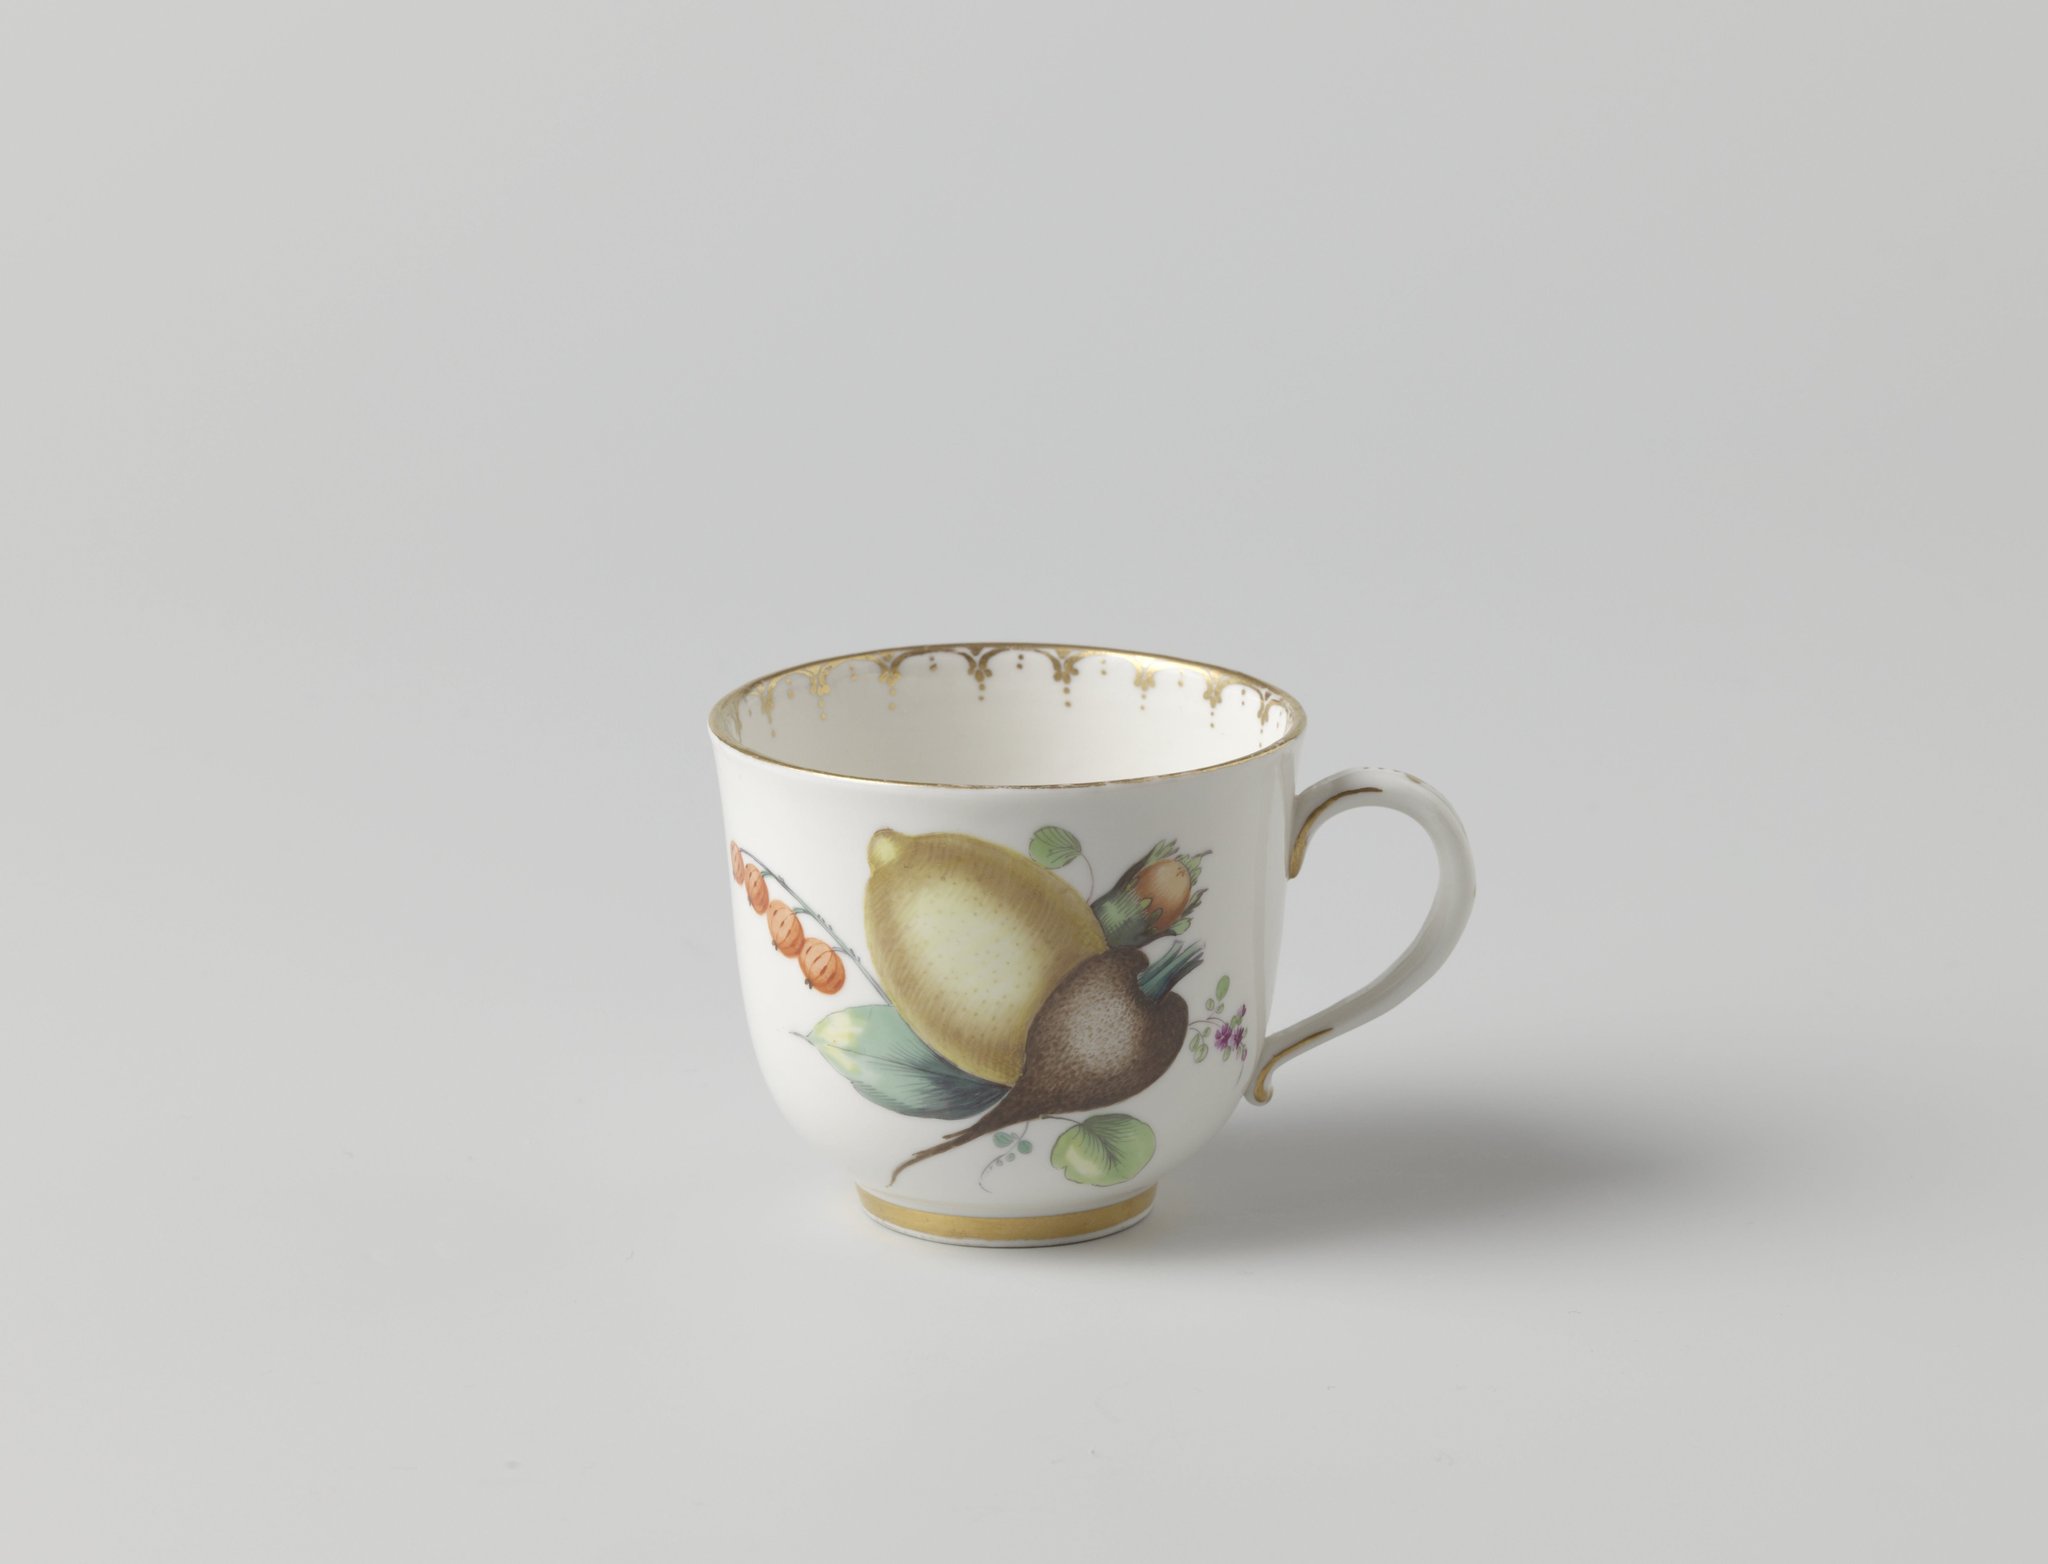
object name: cup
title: Kop, beschilderd met groenten en vruchten omgeven door strooibloemen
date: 1777-1790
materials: porcelain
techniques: painted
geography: the hague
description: Kop, veelkleurig beschilderd met een decor van groenten en vruchten omgeven door strooibloempjes. Gemerkt met een ooievaar in blauw onder de glazuur. N.B. Duits porselein beschilderd in Den Haag.